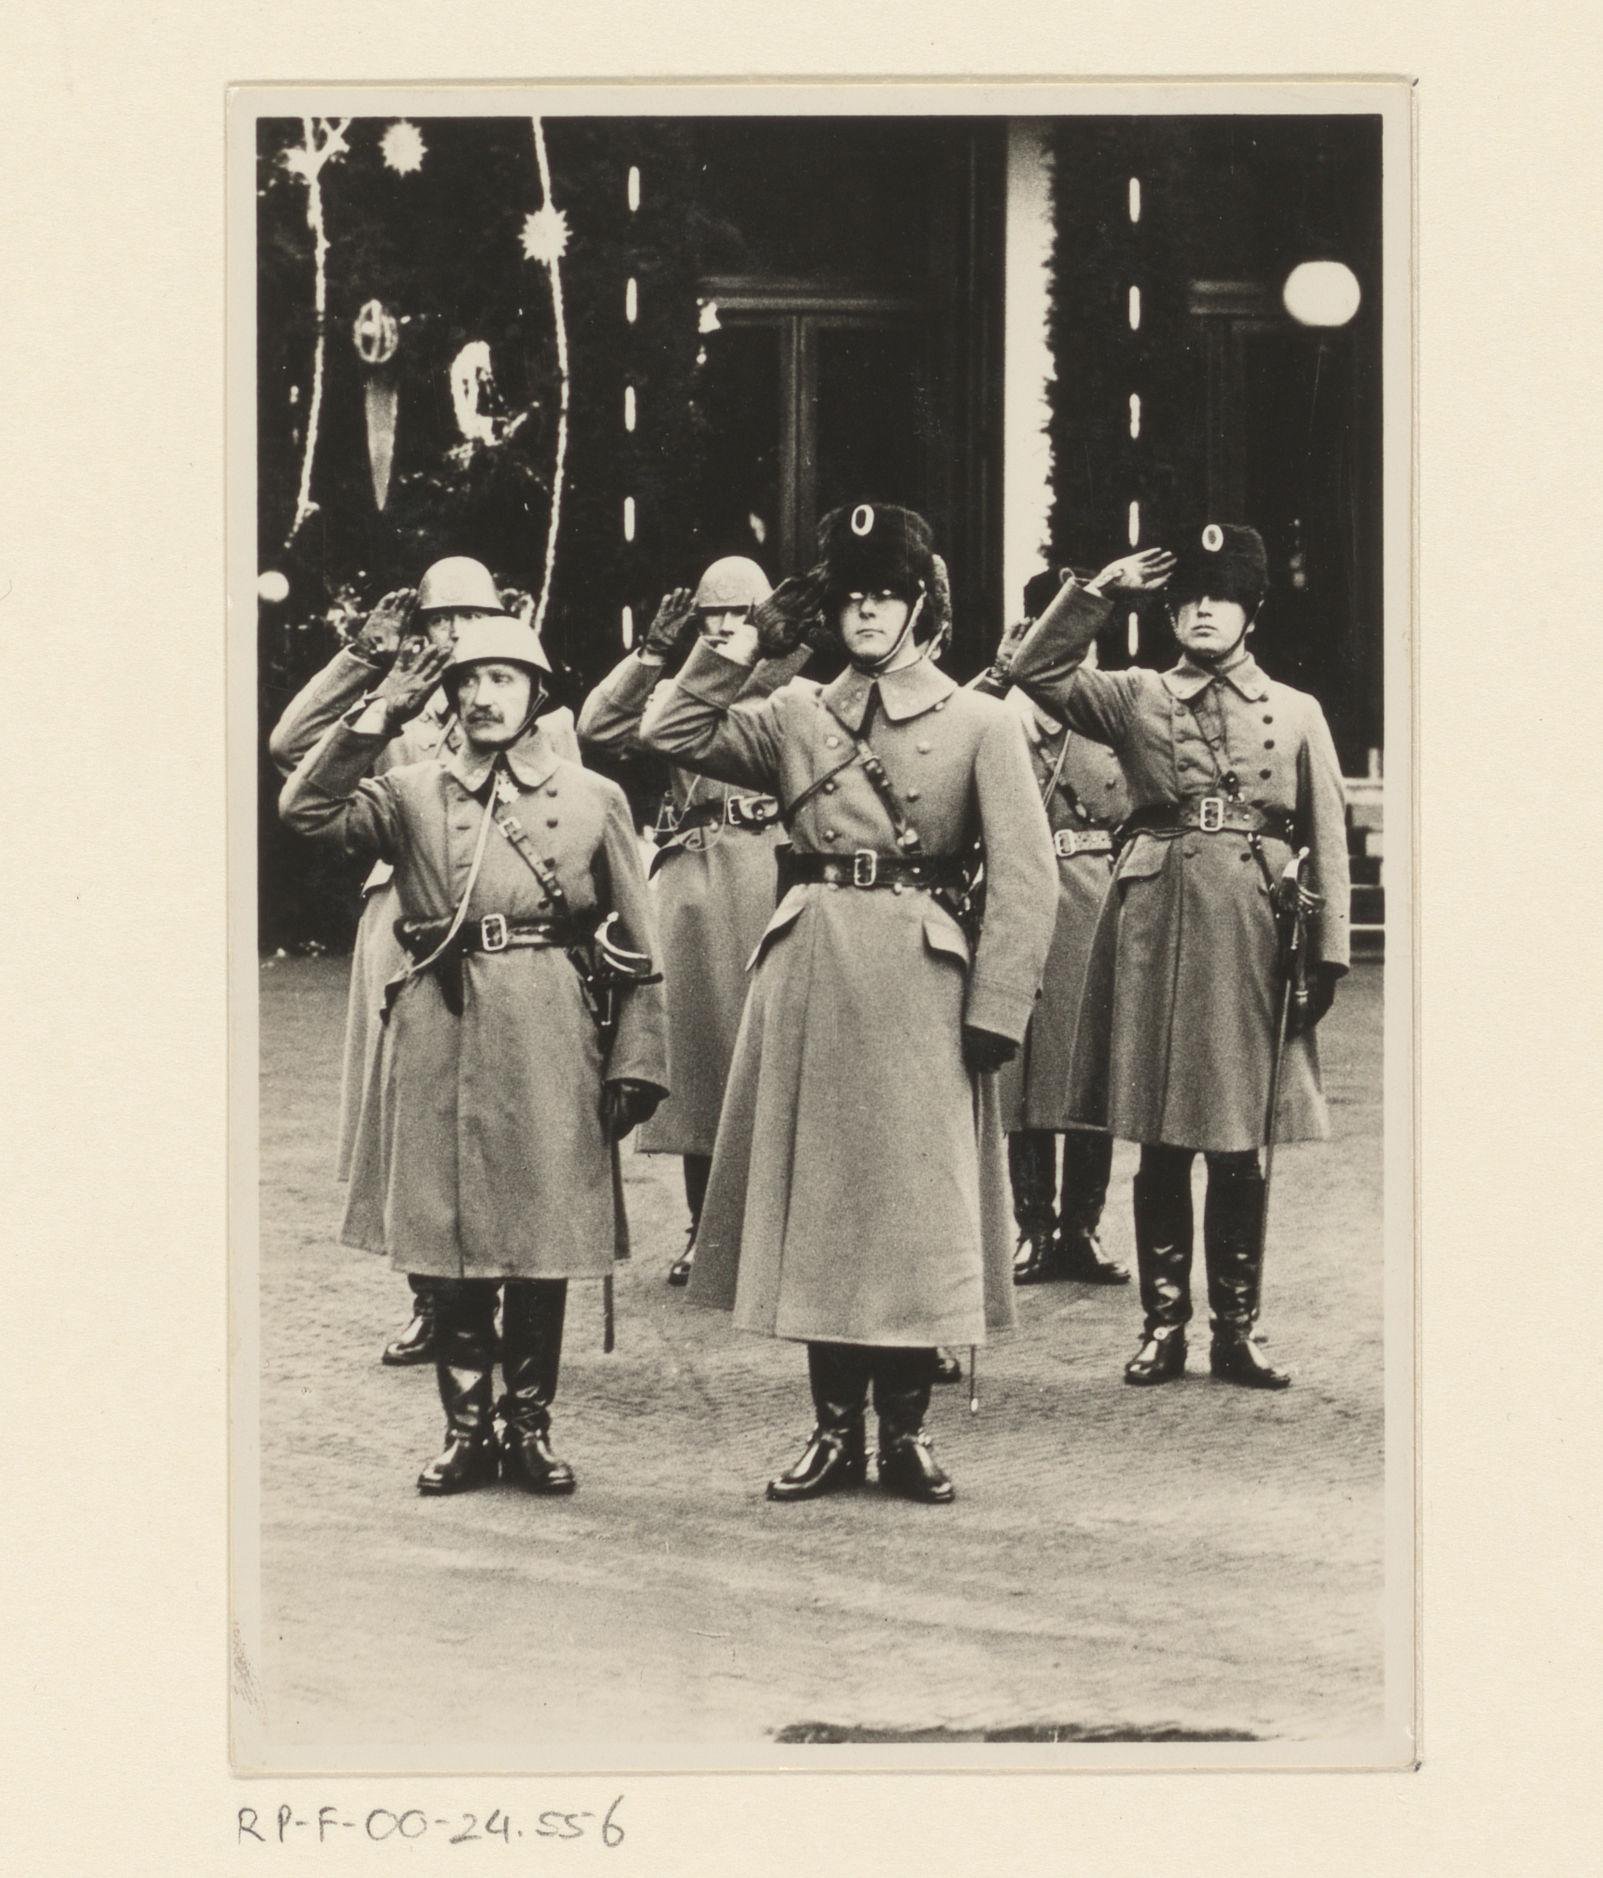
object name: photograph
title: Z.K.H. Prins Bernhard tijdens het defilé bij het Paleis, Noordeinde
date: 1937-1939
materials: paper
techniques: gelatin silver print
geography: the hague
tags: utrecht, bernhard (prins der nederlanden), review, inspection (of company, unit, troop), historical persons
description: Prins Bernhard in uniform staande in de houding, volgens het opschrift tijdens een defilé bij Paleis Noordeinde.